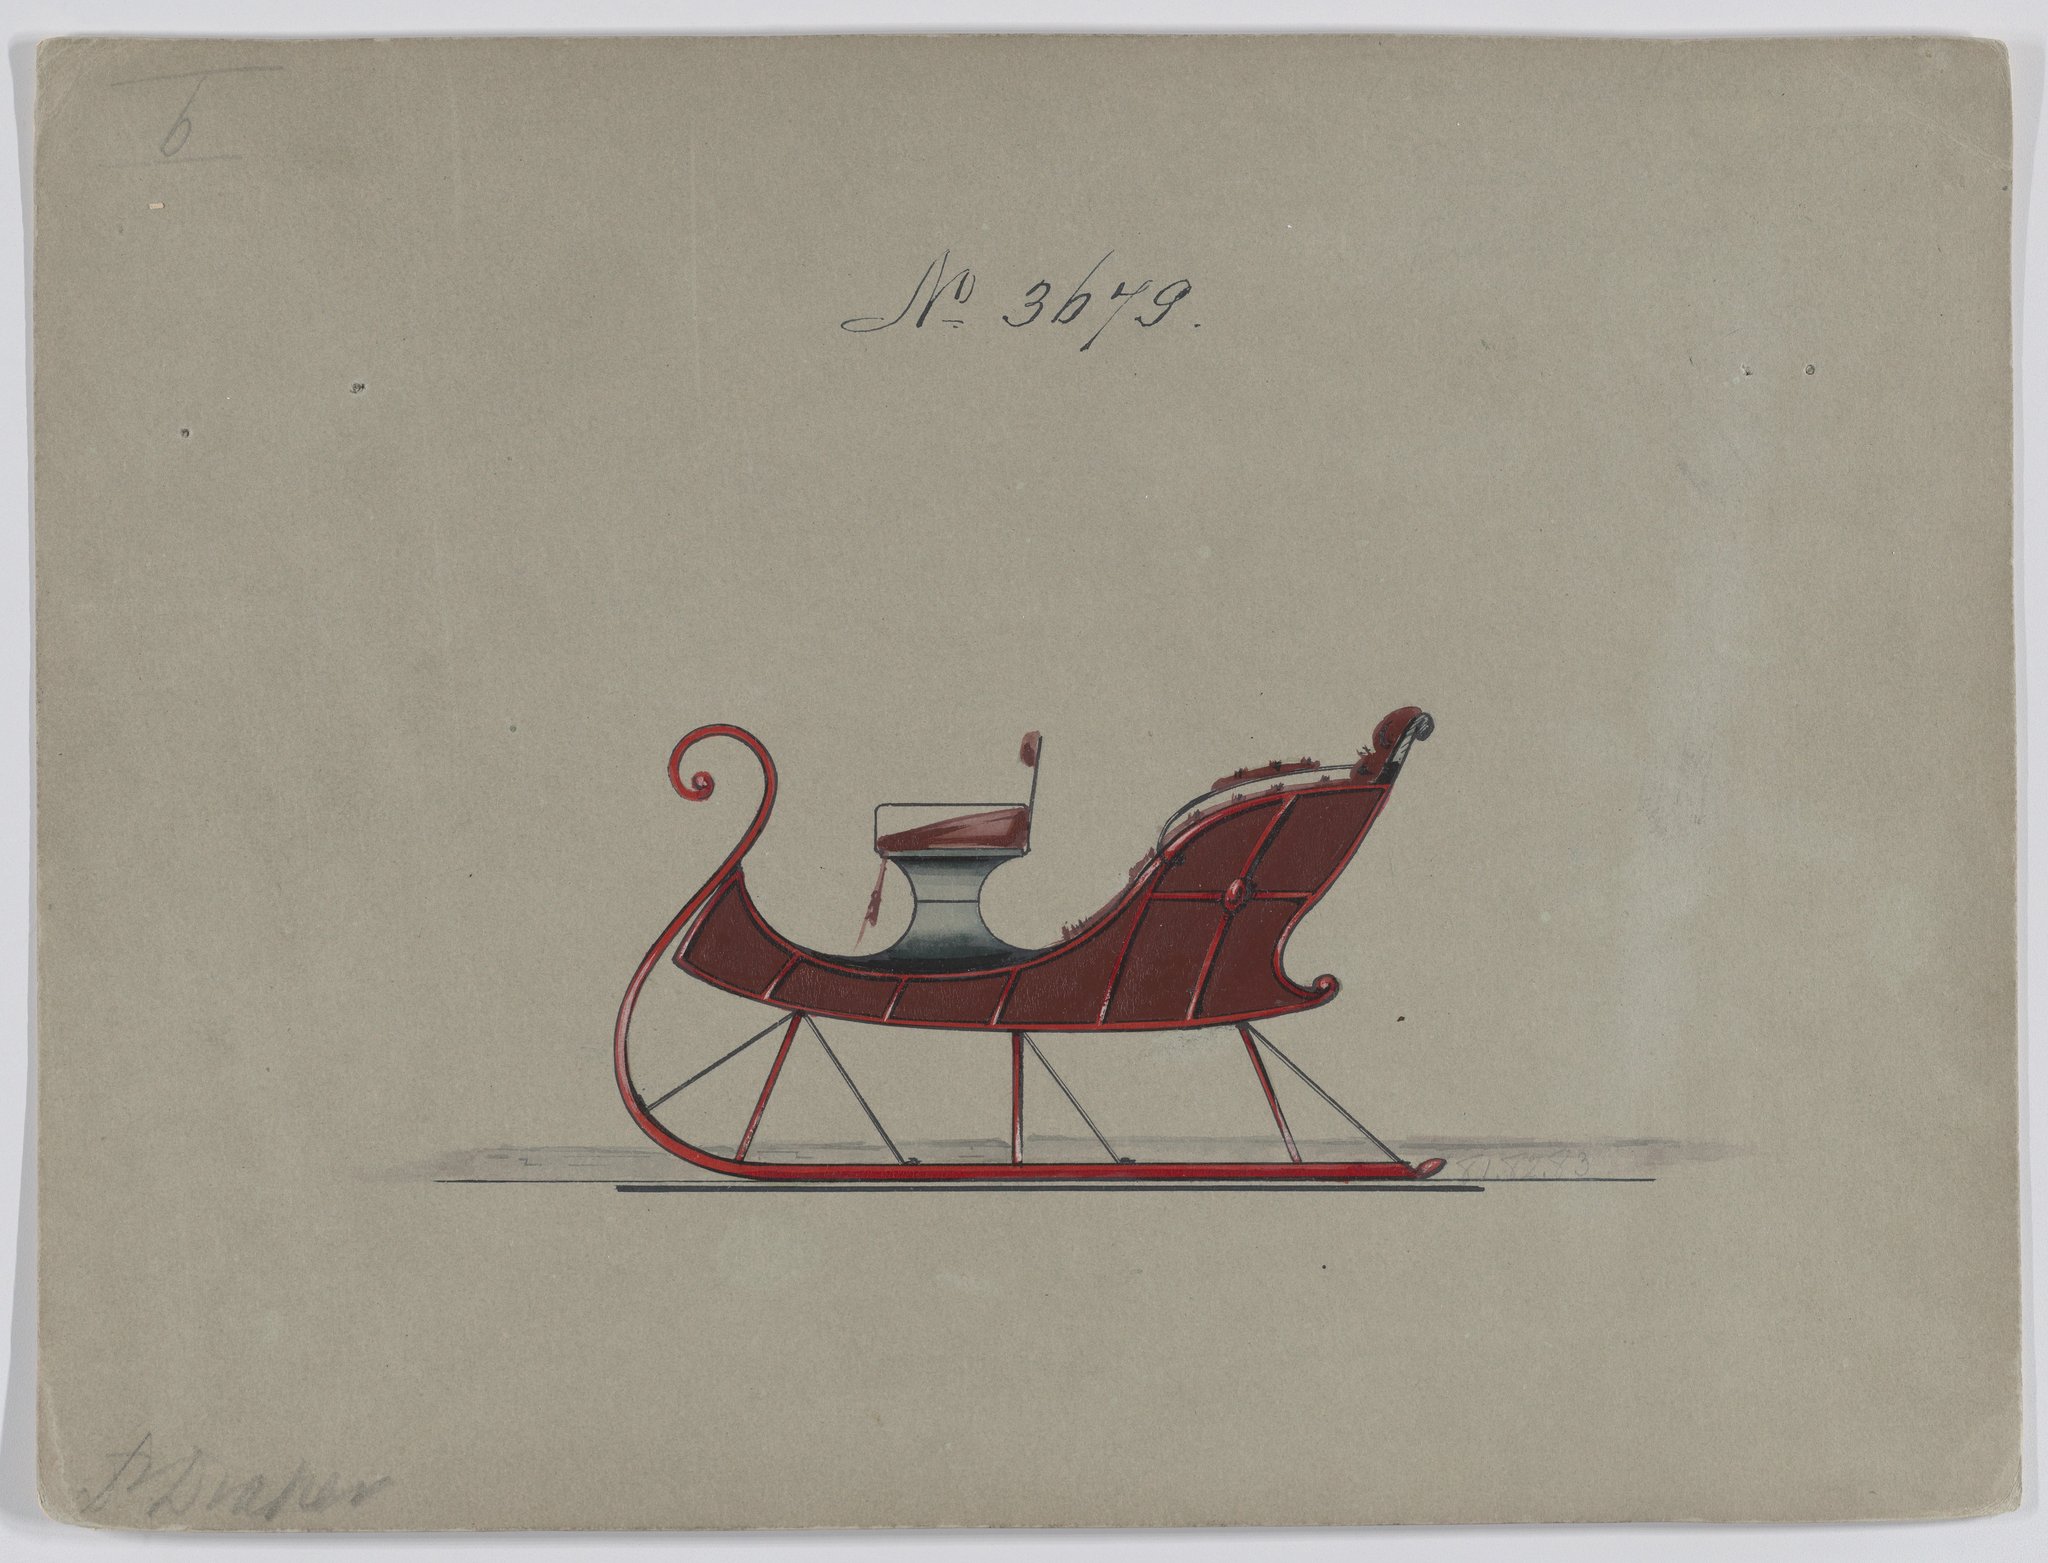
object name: drawing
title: Design for 2 Seat Sleigh, no. 3679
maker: brewster & co.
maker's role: manufacturer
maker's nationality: american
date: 1881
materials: gouache, gum arabic, watercolor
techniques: pen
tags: sleighs